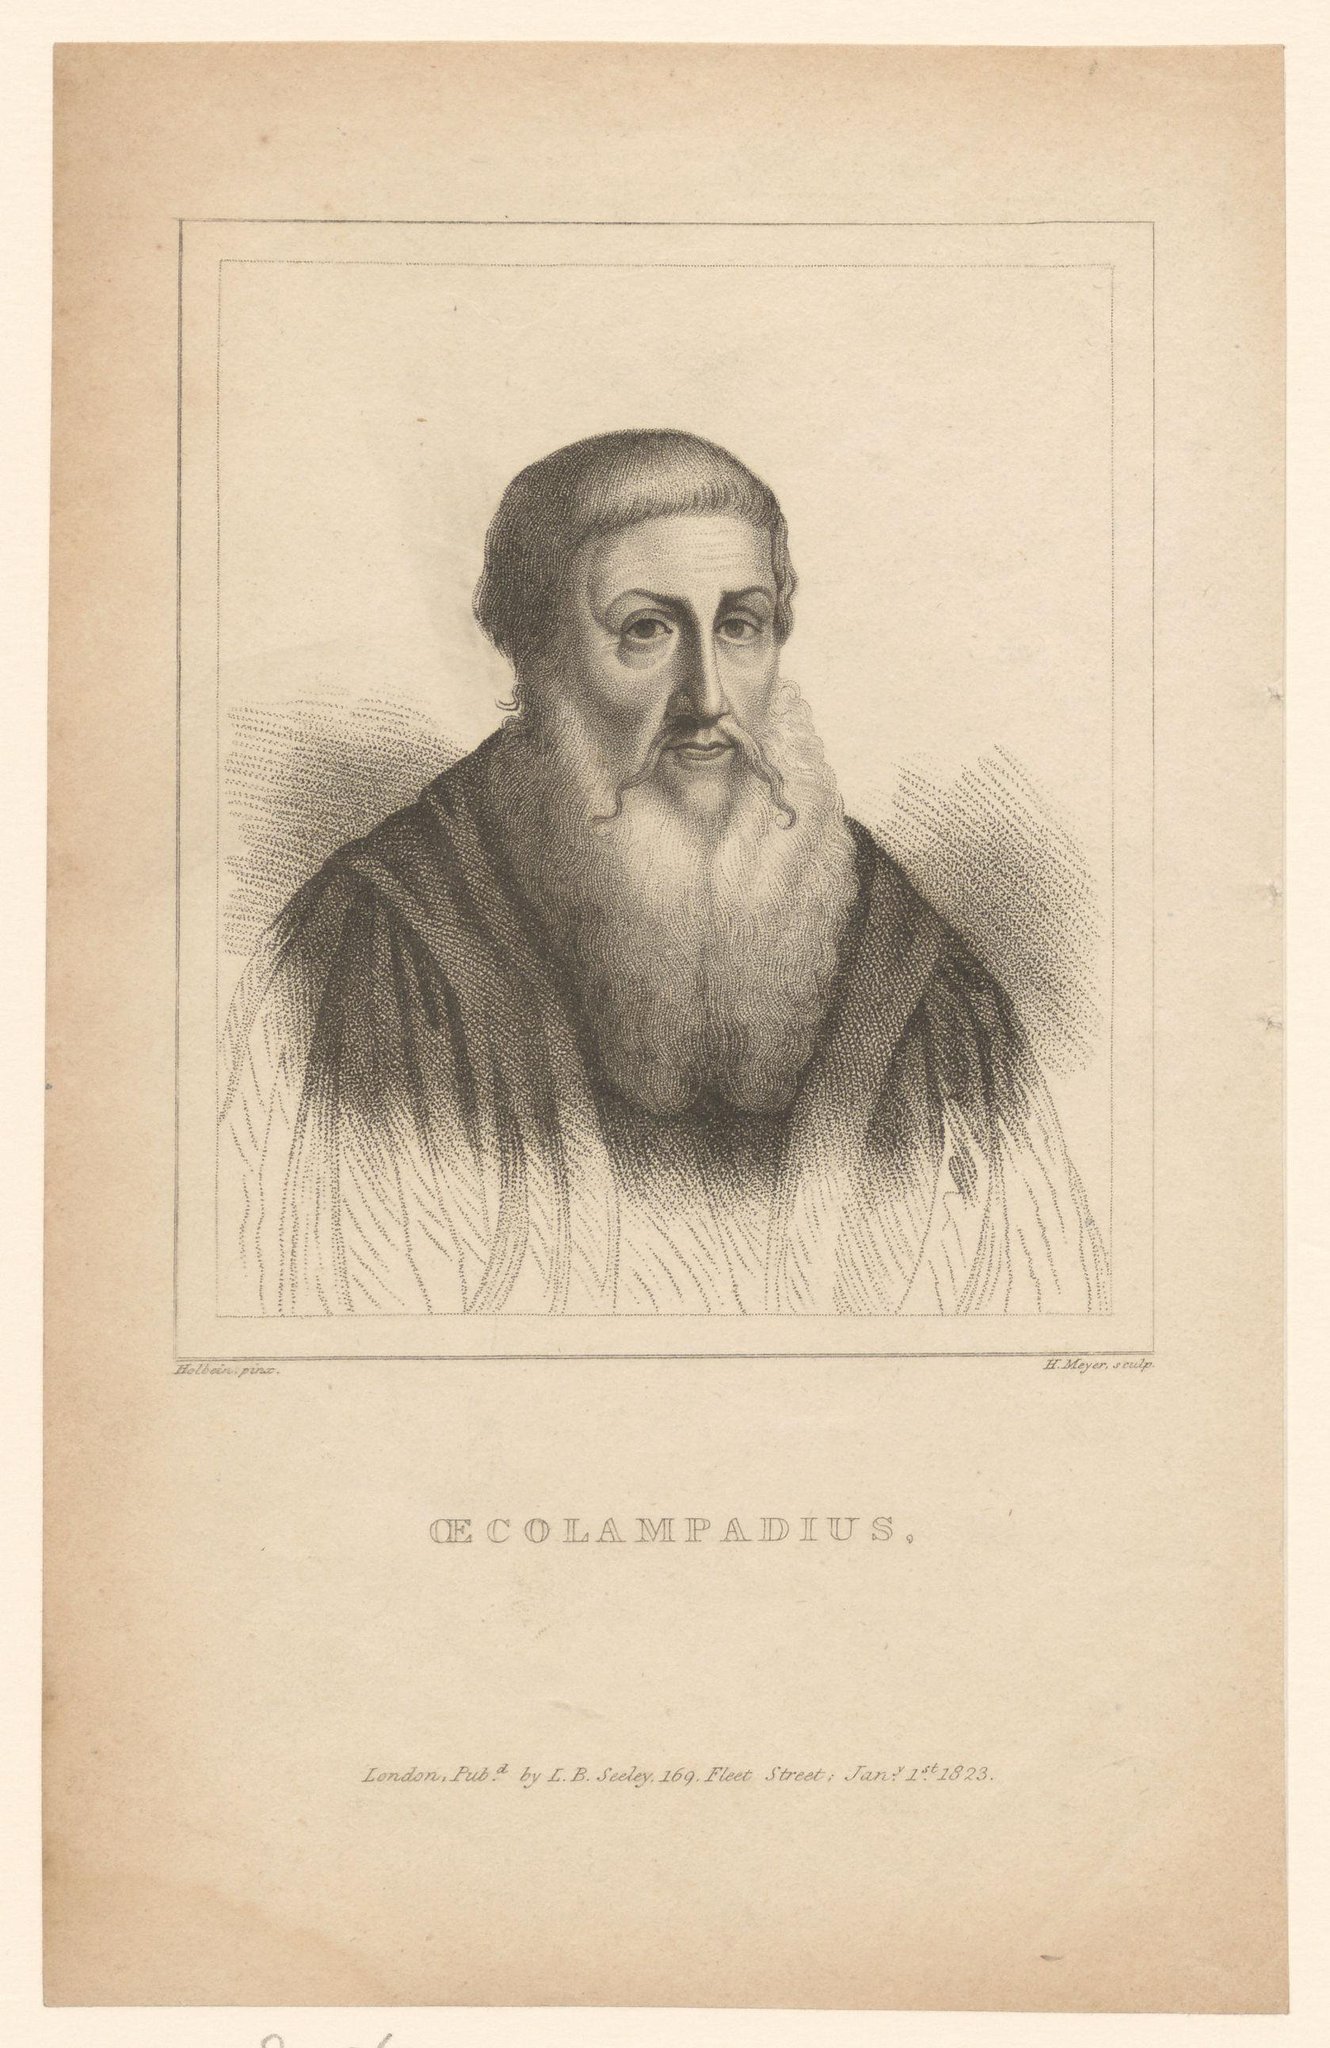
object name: print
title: Portret van Johannes Oecolampadius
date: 1801-1823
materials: paper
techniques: roulette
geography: london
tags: theologian, historical persons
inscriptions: collector's mark: Lugt 2228